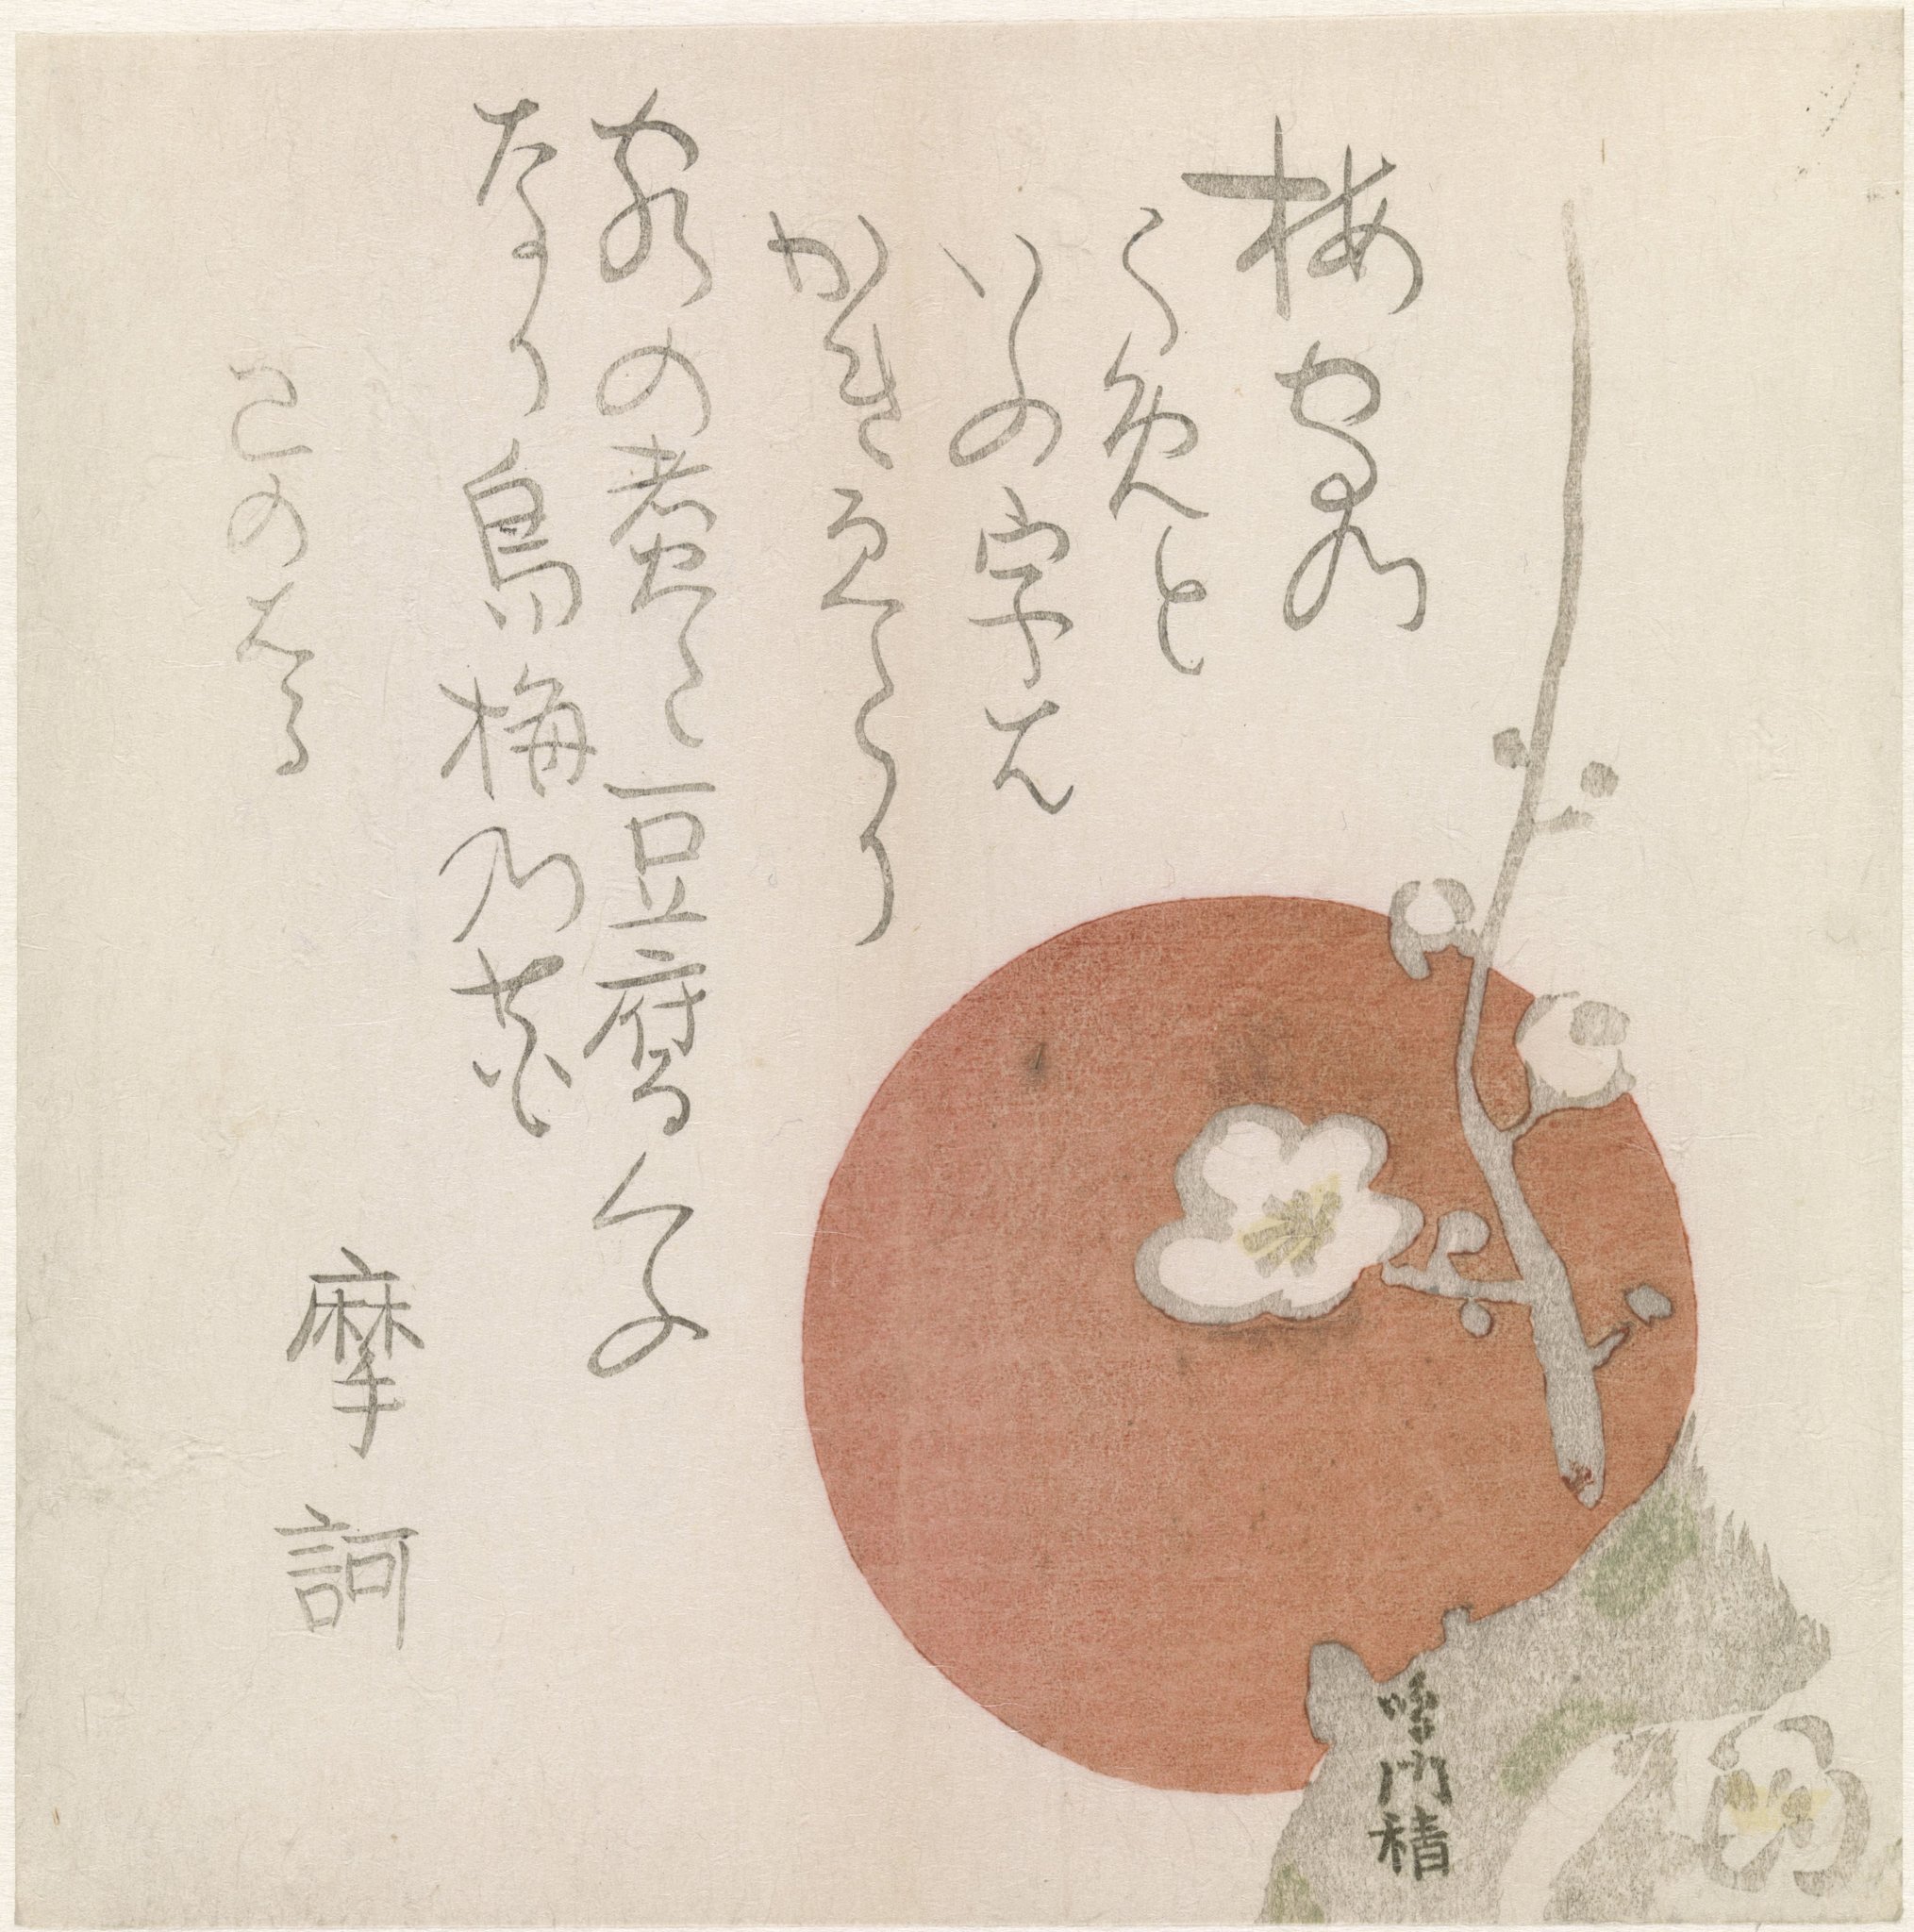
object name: print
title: Bloesem en ondergaande zon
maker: Anonymous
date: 1800-1850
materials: paper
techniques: woodcut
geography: japan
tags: plants; vegetation (+ flowers, blossom, blossoming), sunset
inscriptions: collector's mark: Lugt 2228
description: Een surimono is een luxe uitgevoerde prent waarop beeld met één of meerdere gedichten gecombineerd is. Bij het drukken van een surimono werd vaak gebruik gemaakt van dikker papier, blinddruk en metaal pigmenten, zoals koper- en zilverpoeder. De prenten werden vaak in opdracht van dichters gemaakt en als exclusief geschenk aan vrienden en relaties gegeven.